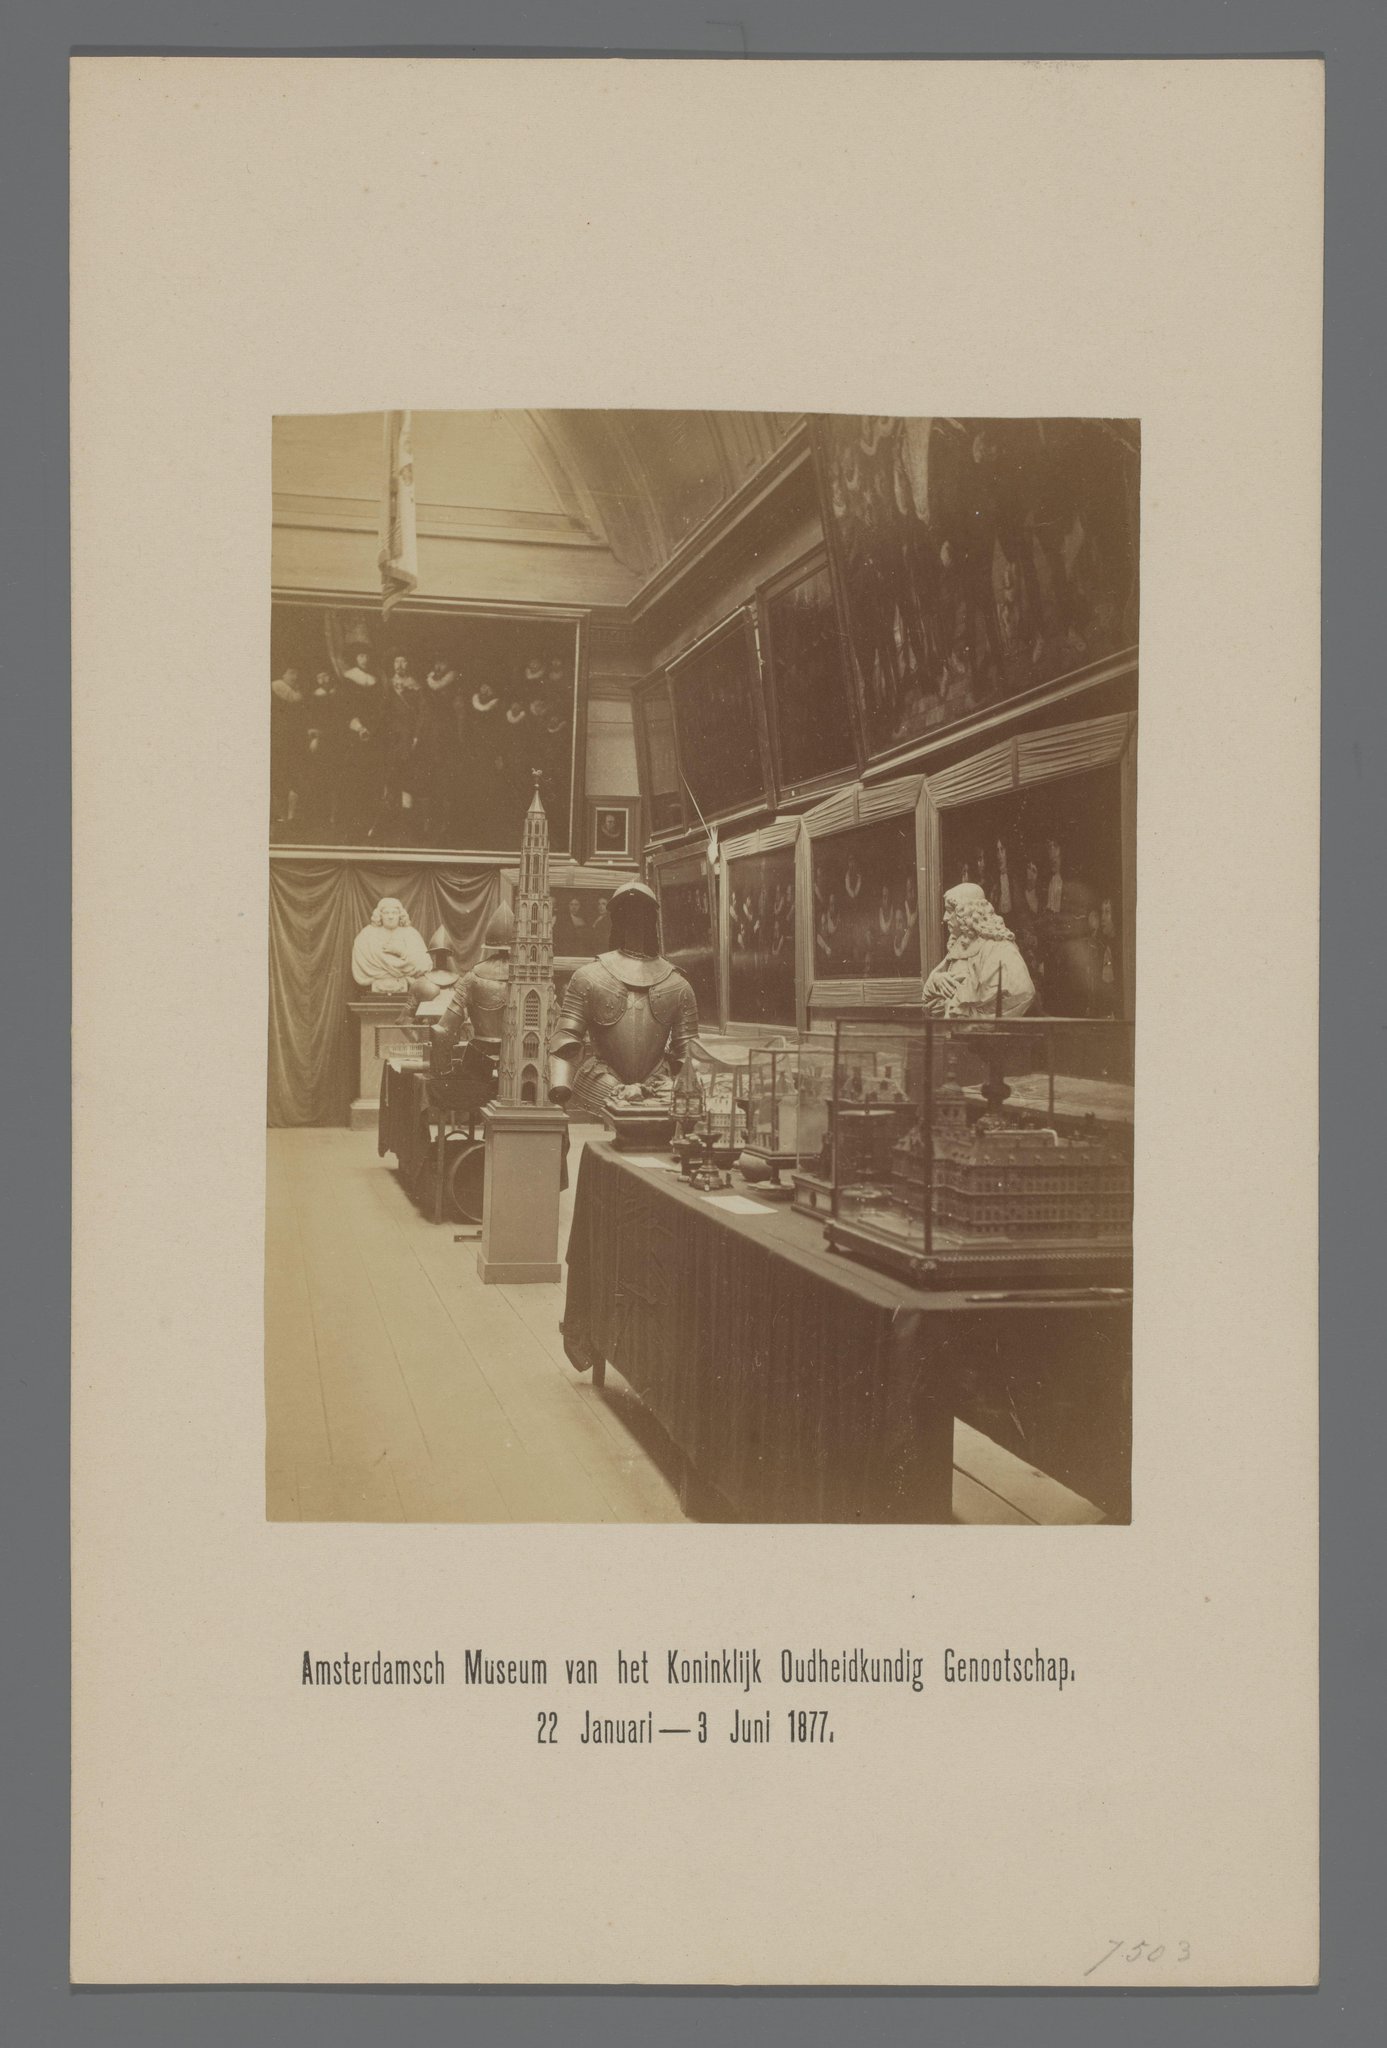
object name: photograph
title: Tentoonstellingsruimte van het Amsterdamsch Museum in het Oudemannenhuis te Amsterdam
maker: pieter oosterhuis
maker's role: draughtsman, print maker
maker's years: 1816-1885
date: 1877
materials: cardboard, paper, photographic support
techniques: albumen print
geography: amsterdam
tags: permanent exhibition, museum, collection, exhibition, show, amsterdam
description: Interieur van een zaal van het Museum van het Koninklijk Oudheidkundig Genootschap in het Oudemannenhuis te Amsterdam, geopend 22 januari - 3 juni 1877.